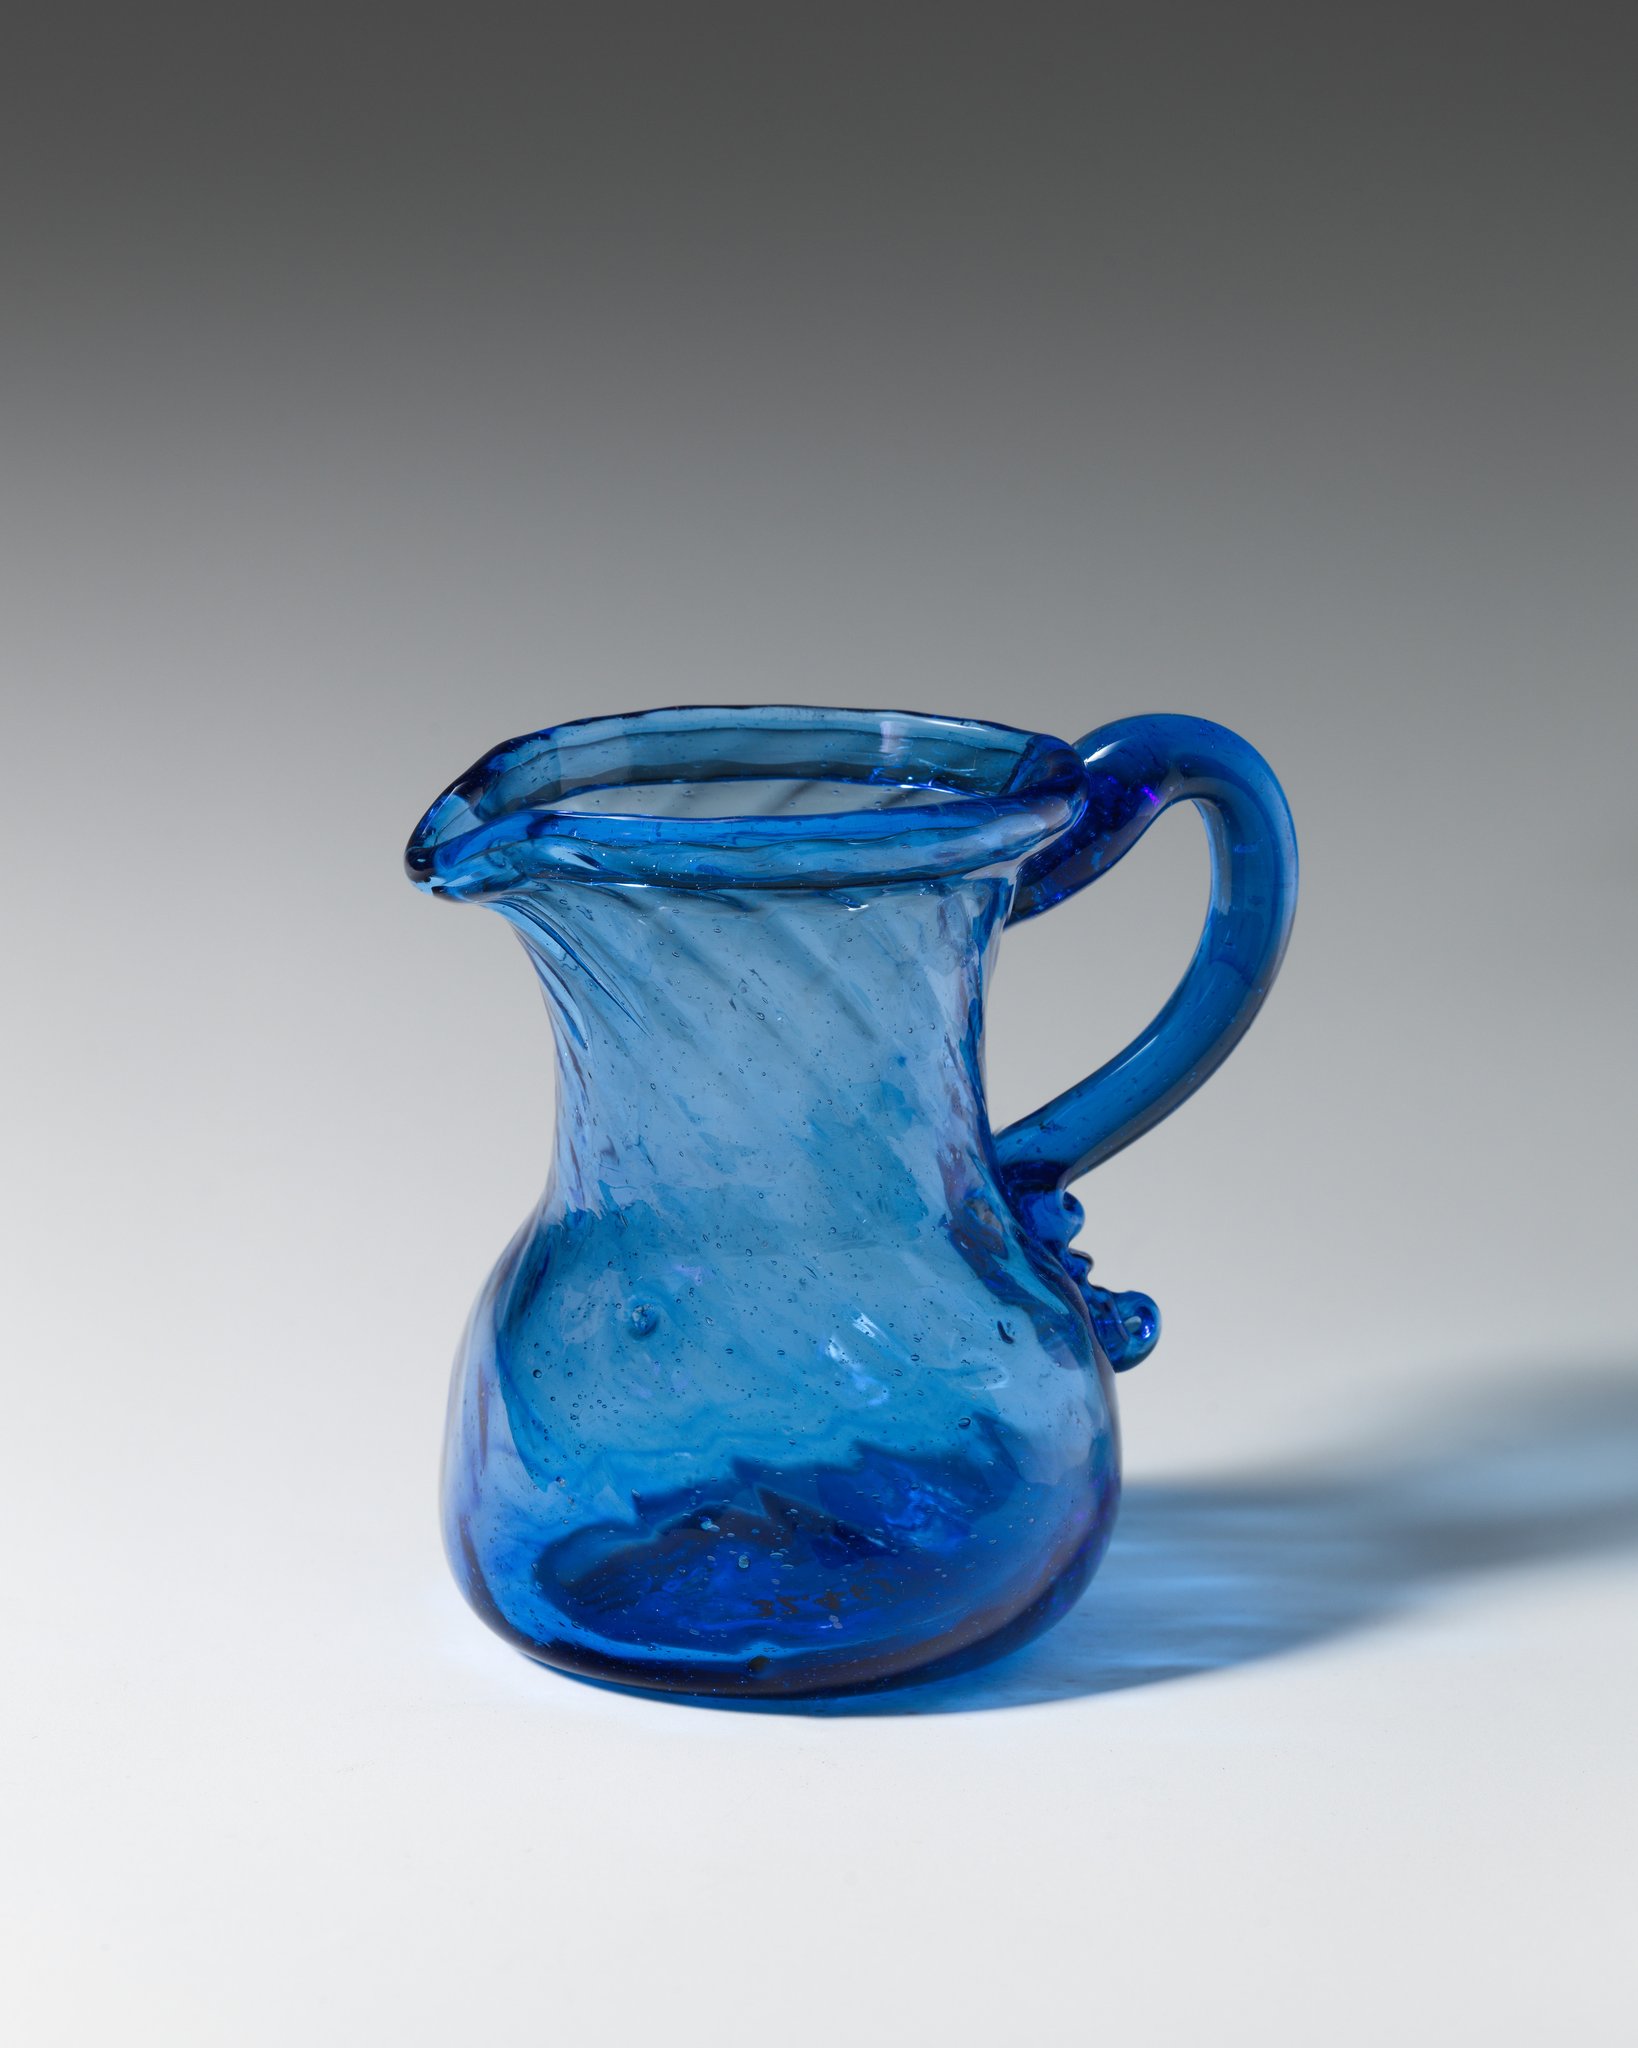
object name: milk jug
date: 1750-1800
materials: glass